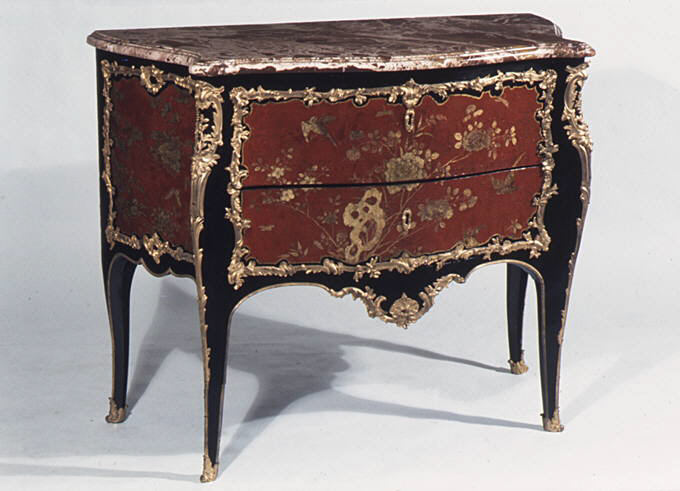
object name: commode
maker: jean desforges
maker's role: maker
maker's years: 1740-1757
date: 1745-1750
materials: gilt bronze, lacquer, marble, wood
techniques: lacquer, veneering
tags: chinoiserie,flowers